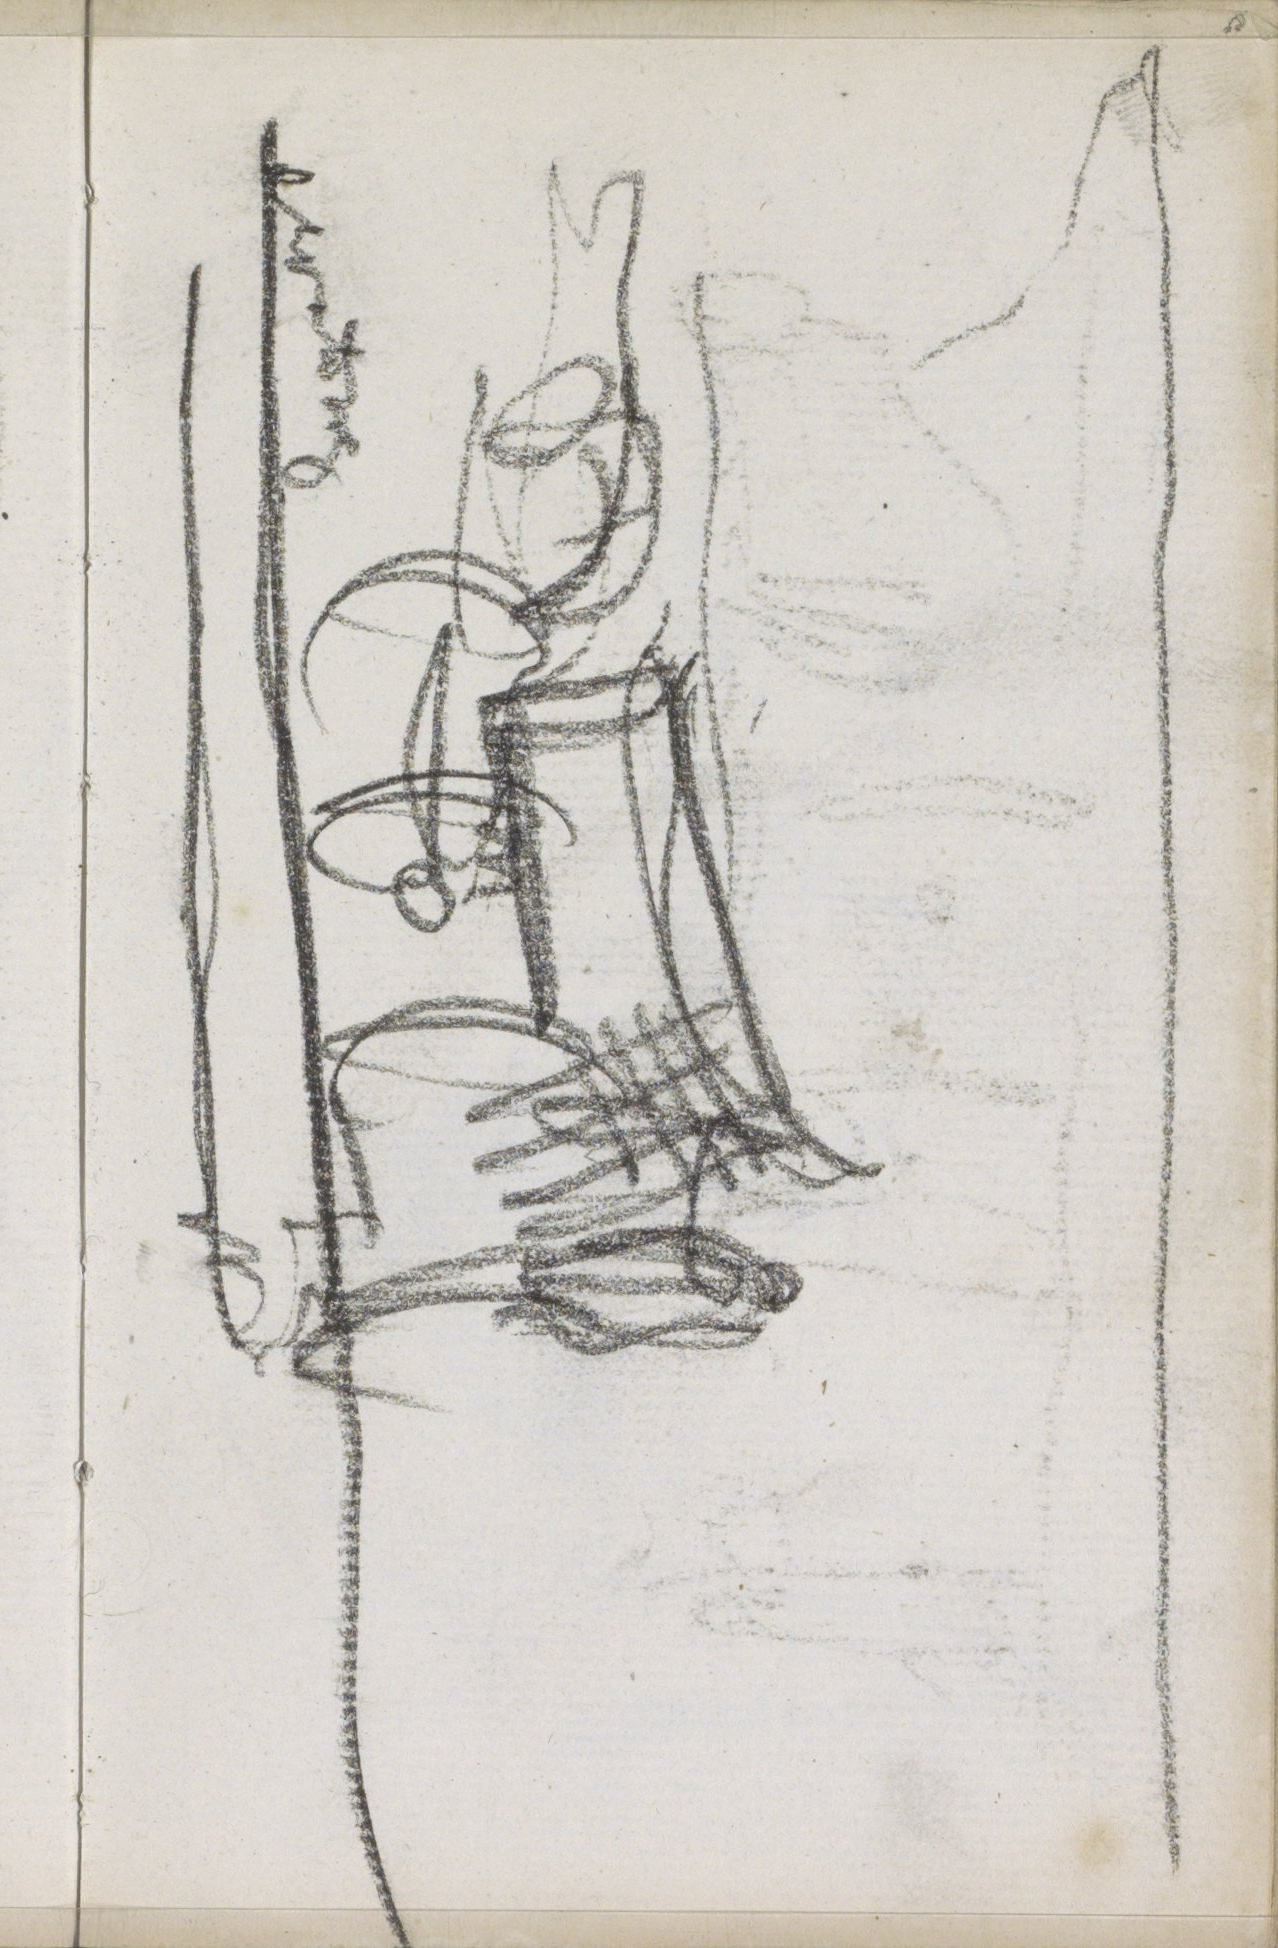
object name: sketchbook leaf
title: Kar of ploeg in een landschap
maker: george hendrik breitner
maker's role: draughtsman, painter, print maker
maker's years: 1857-1923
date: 1884-1886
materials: chalk, paper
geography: drenthe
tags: landscapes, agricultural implements: plough, (farm) wagon, freight wagon, cart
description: Pagina 68 uit een schetsboek met 67 bladen vervaardigd in Drenthe.